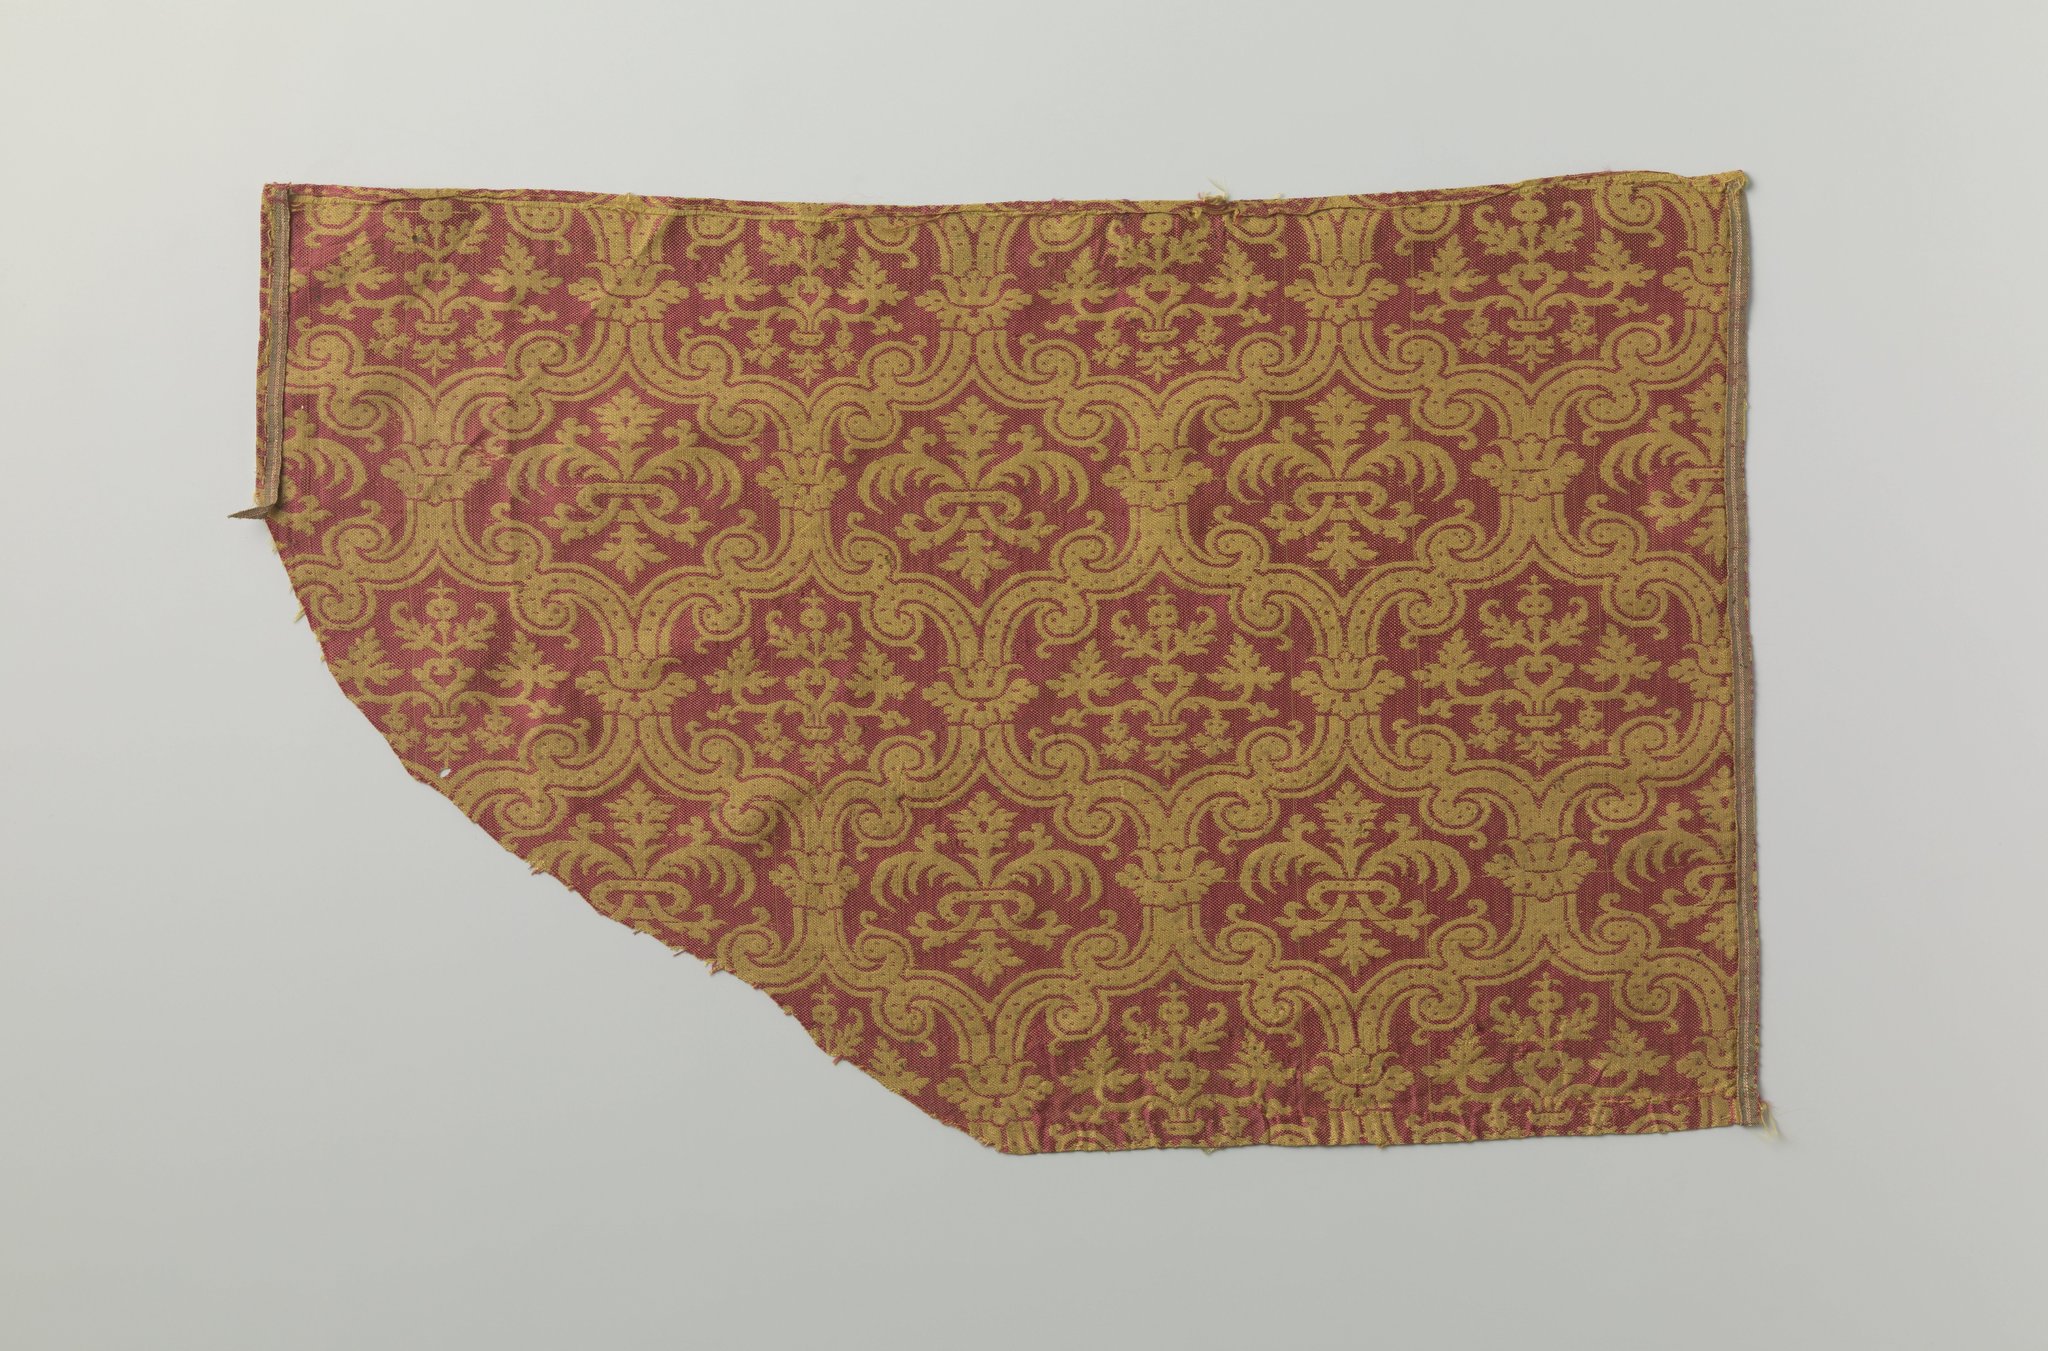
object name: silk textile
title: Fragment rood en geel zijdeweefsel met gestileerde bloem- en bladmotieven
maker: Anonymous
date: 1550-1600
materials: silk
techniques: double-sided binding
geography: italy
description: Fragment gele zijde met patroon in rood en geel van gerekte ovalen gevormd door gekrulde voluten en gevuld met bladwerk.